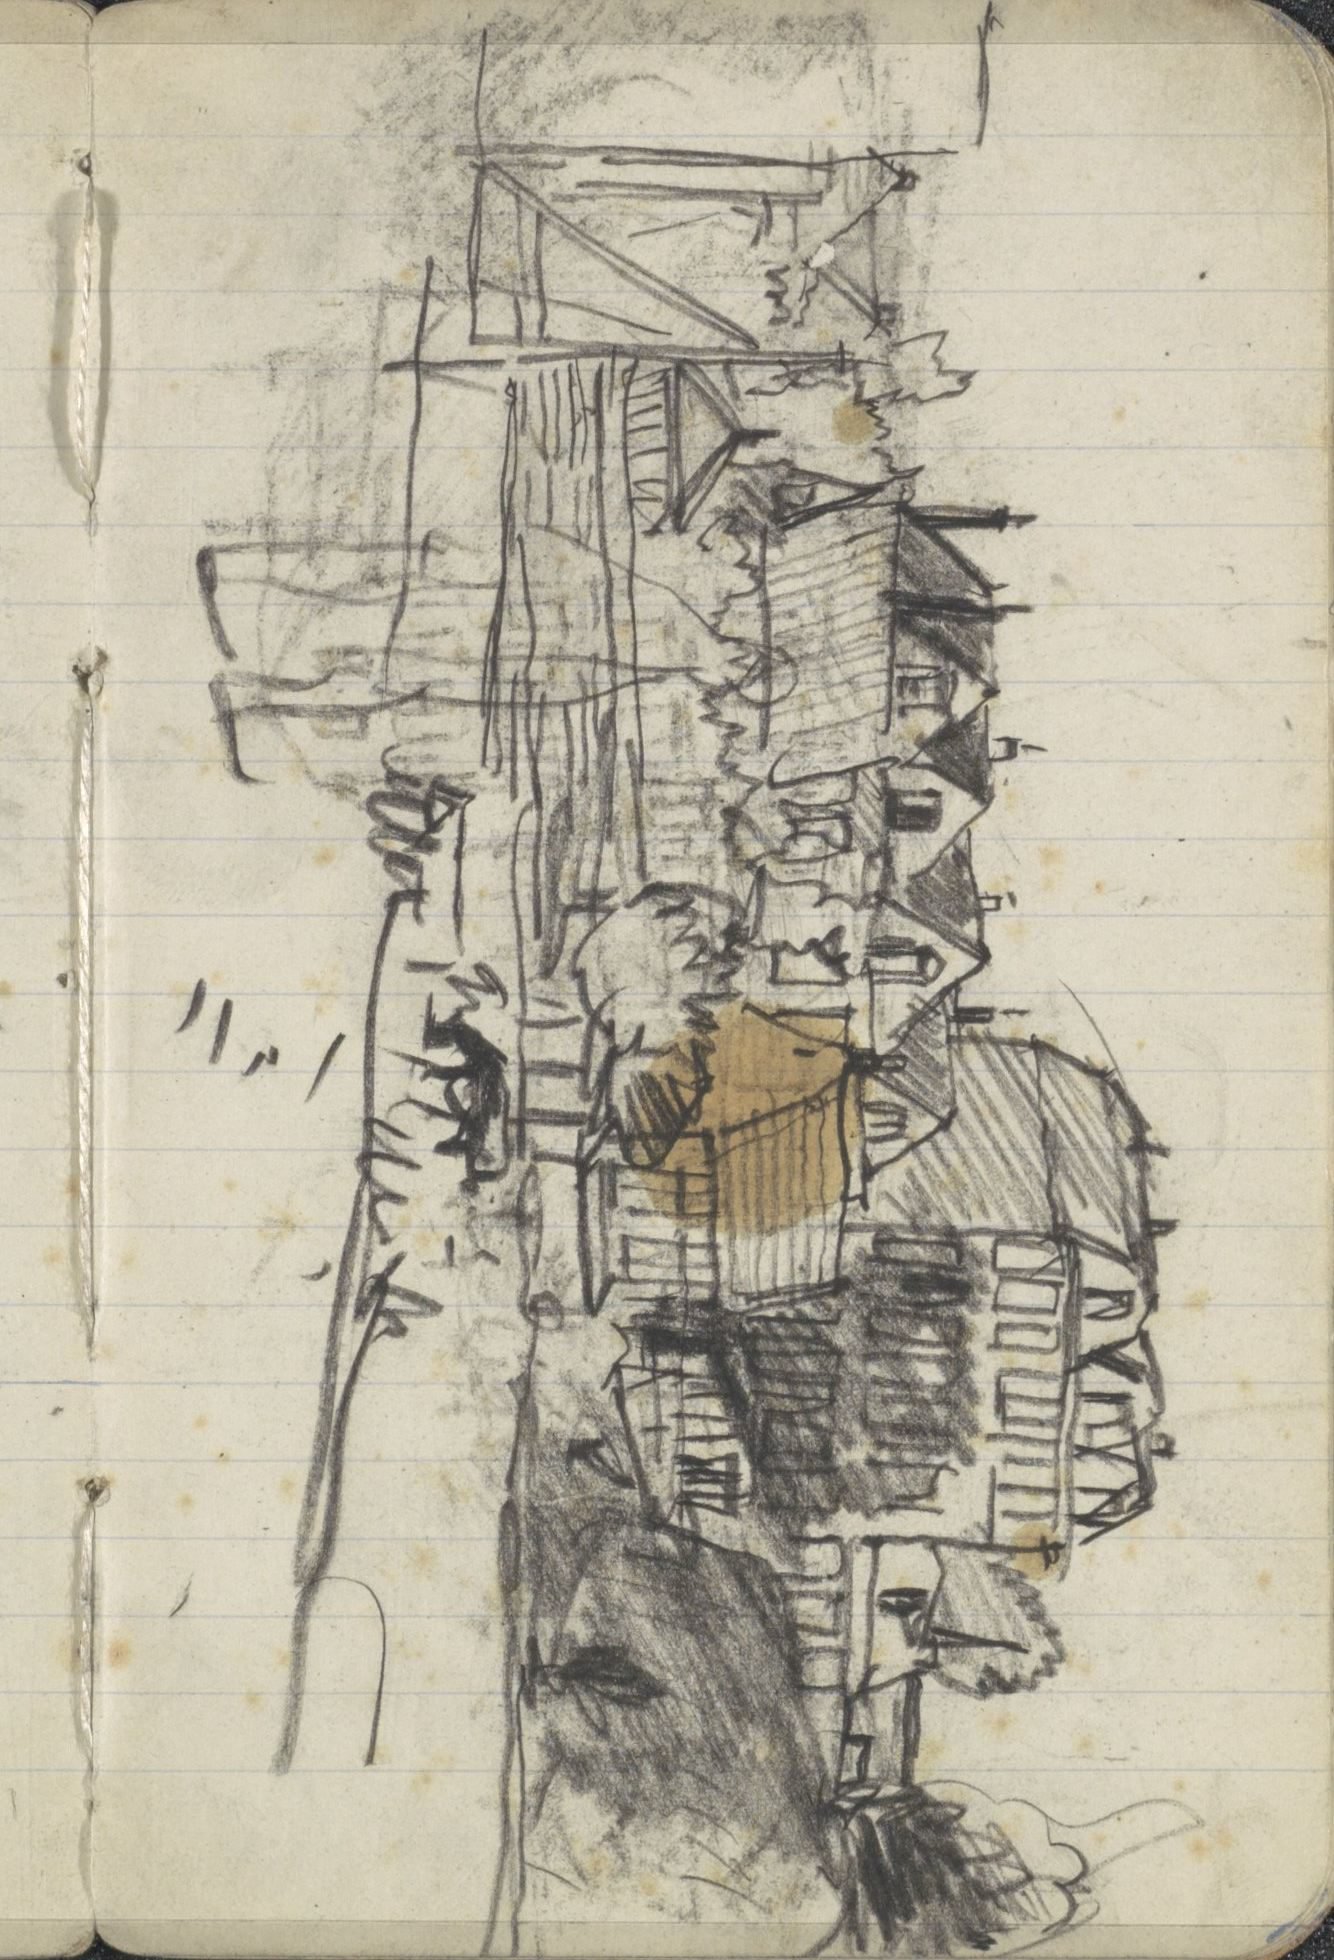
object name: sketchbook leaf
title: Gezicht in Amsterdam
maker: george hendrik breitner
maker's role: draughtsman, painter, print maker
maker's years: 1857-1923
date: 1896-1897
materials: chalk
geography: amsterdam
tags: civic architecture; edifices; dwellings, city-view, and landscape with man-made constructions (+ city(-scape) with figures, staffage), amsterdam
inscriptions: kleurnotitie, handgeschreven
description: Vooraan een figuur. Pagina 66 uit een schetsboek met 39 bladen.